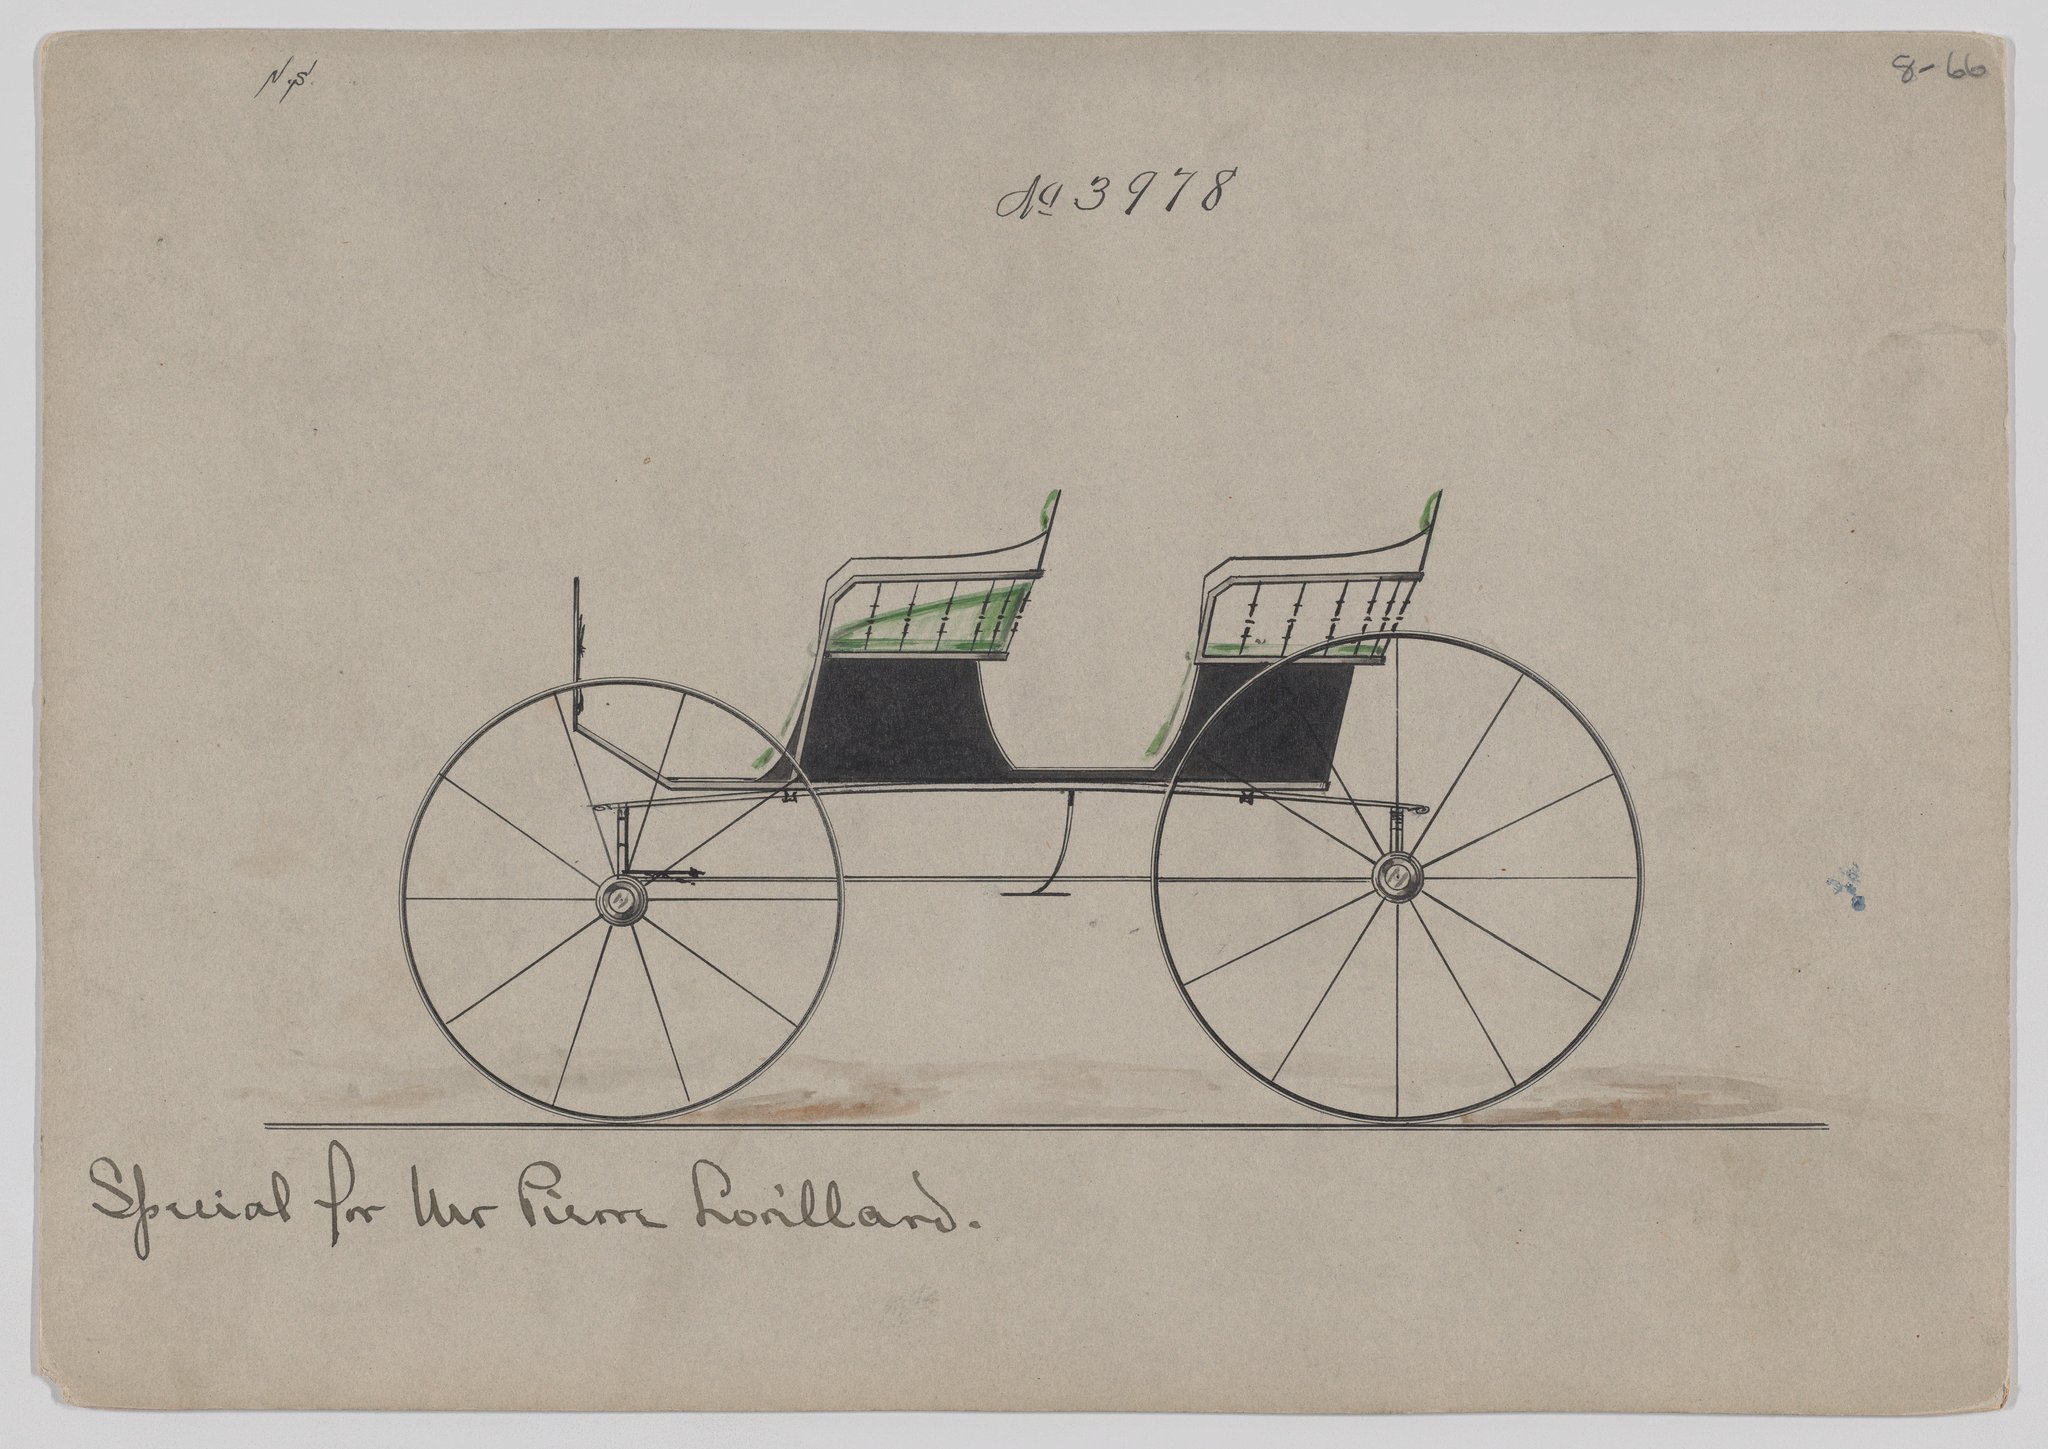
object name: drawing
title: Design for 2 seat Side Bar Phaeton or Wagon (?), no top, no. 3978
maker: brewster & co.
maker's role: manufacturer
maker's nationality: american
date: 1886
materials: gouache, ink, watercolor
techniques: pen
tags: carriages